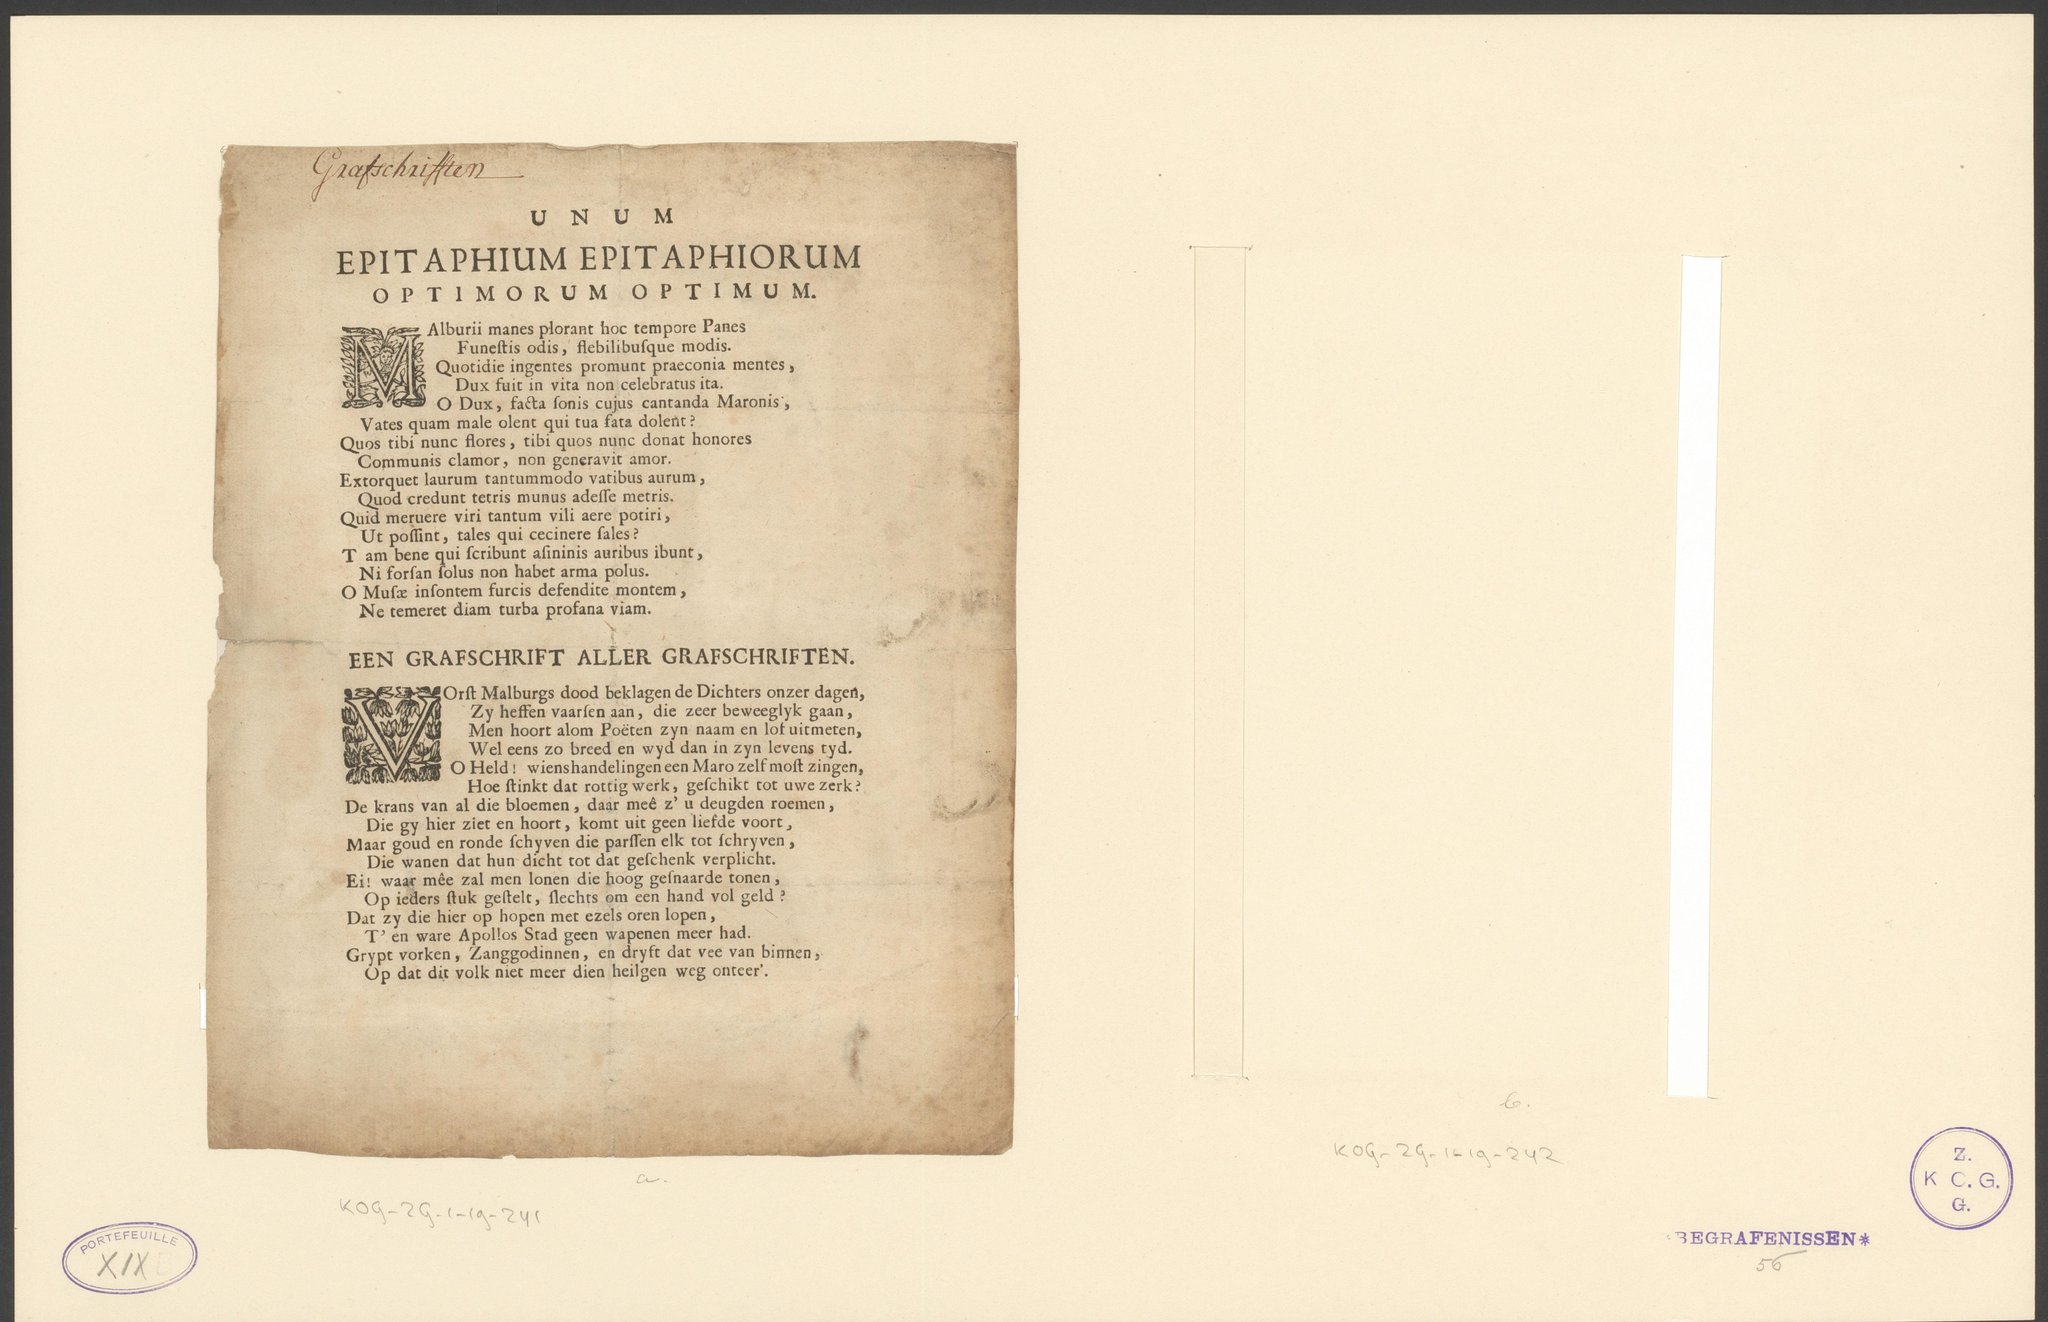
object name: poem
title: Twee grafschriften voor de vorst van Malburg, overleden 1722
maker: Anonymous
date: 1722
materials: paper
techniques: letterpress printing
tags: mourning card, death notice, obituary, epitaph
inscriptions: collector's mark, collector's mark: Lugt 1641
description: Twee grafschriften in het Latijn en Nederlands voor de 'vorst van Malburg', overleden 1722. Mogelijk gaat het om Frederik Willem Adolf graaf van Nassau-Siegen. Onderwerpsrubrieken binnen de Atlas Zeden en Gewoonten: Des Menschen Begin, Midden en Einde. Begrafenissen, lijkzangen, grafschriften, pamfletten.